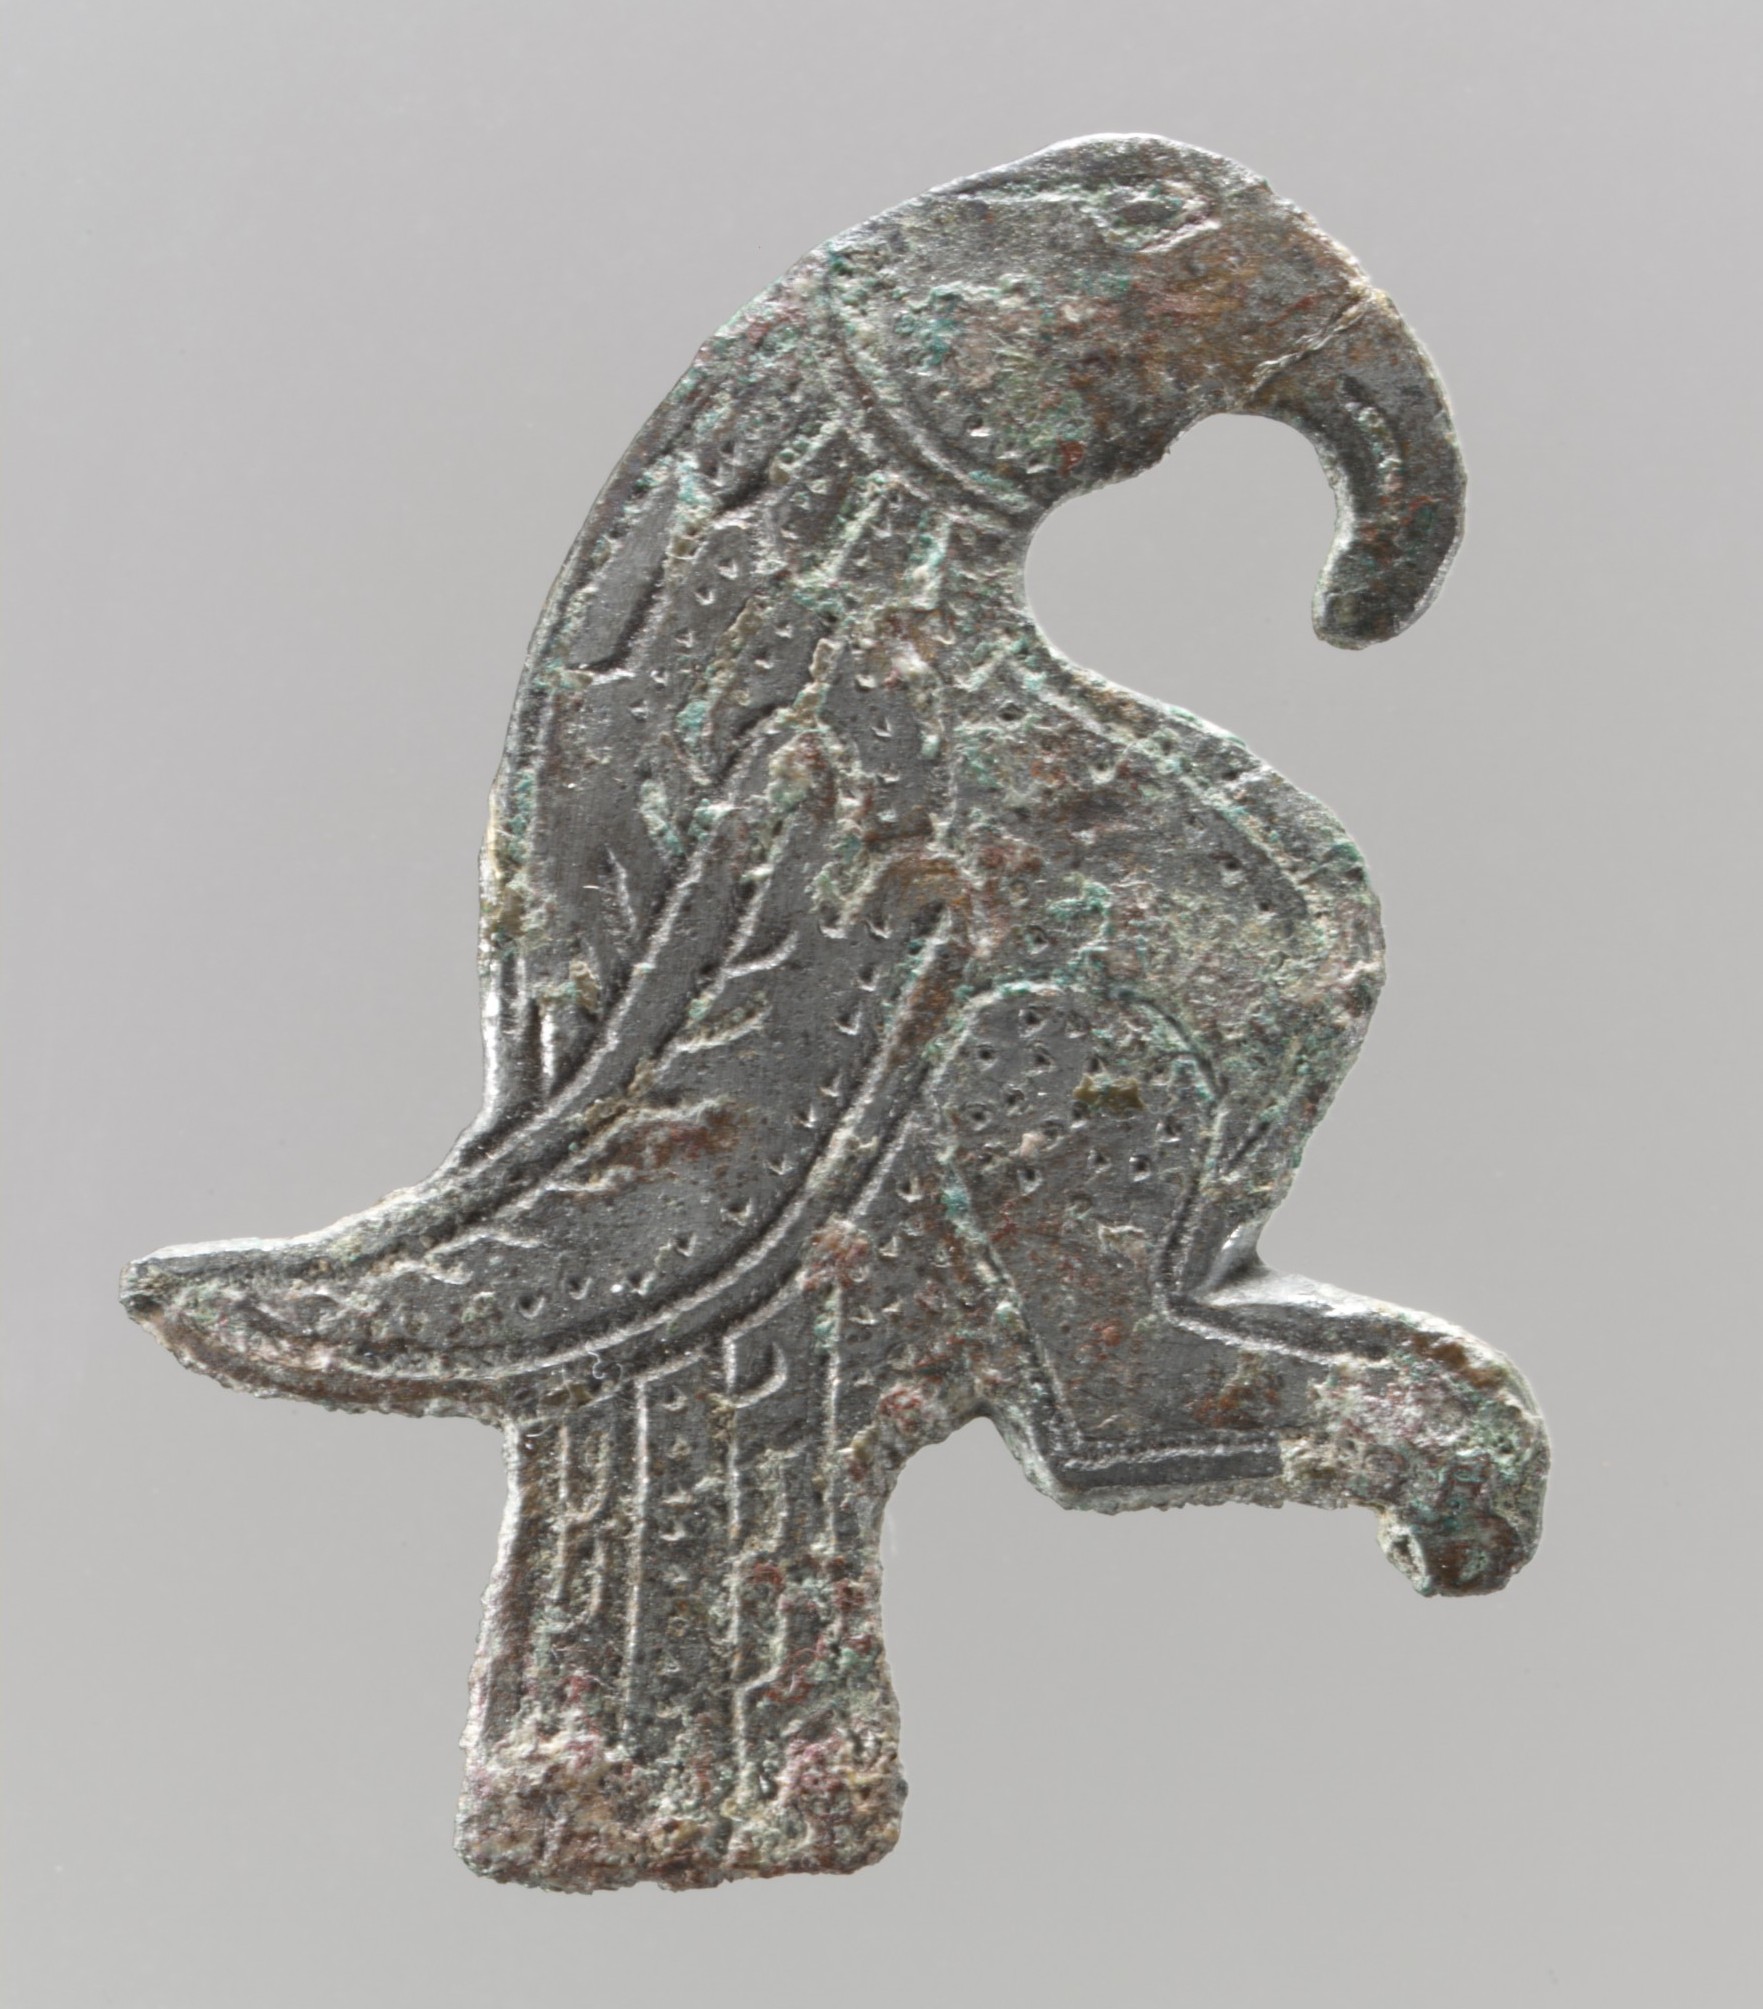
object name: mount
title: Purse Mount in the Form of a Bird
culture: frankish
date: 551-600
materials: copper alloy